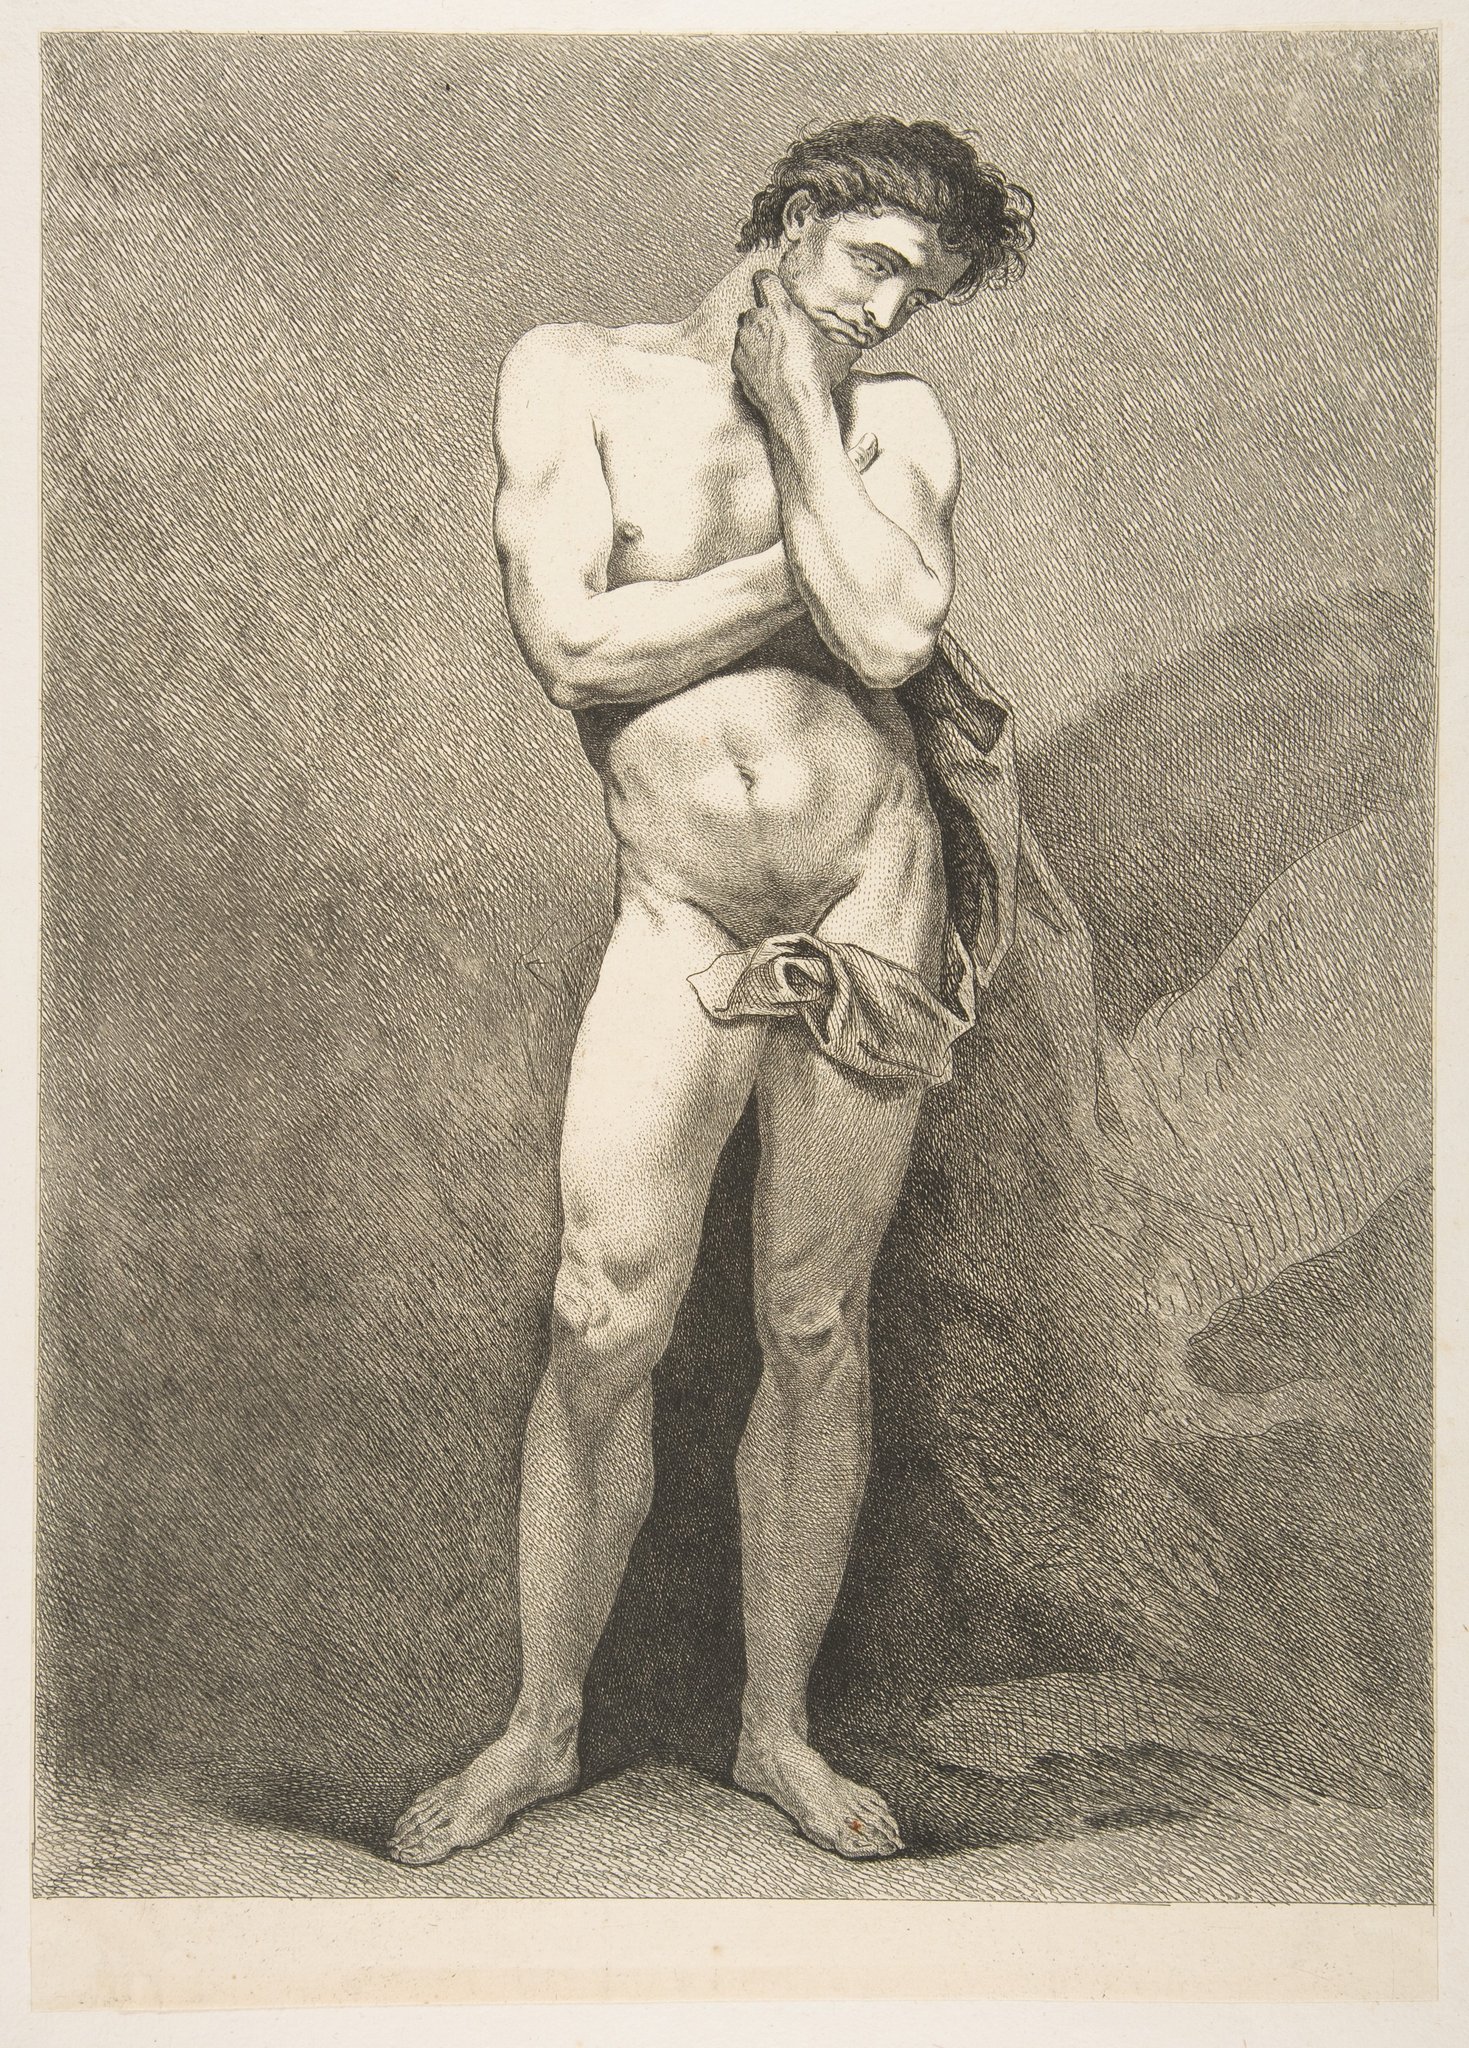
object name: print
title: An "Académie": Standing Man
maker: carle (charles andré) vanloo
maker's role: artist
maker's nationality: french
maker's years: 1705-1765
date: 1742-1743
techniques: etching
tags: male nudes